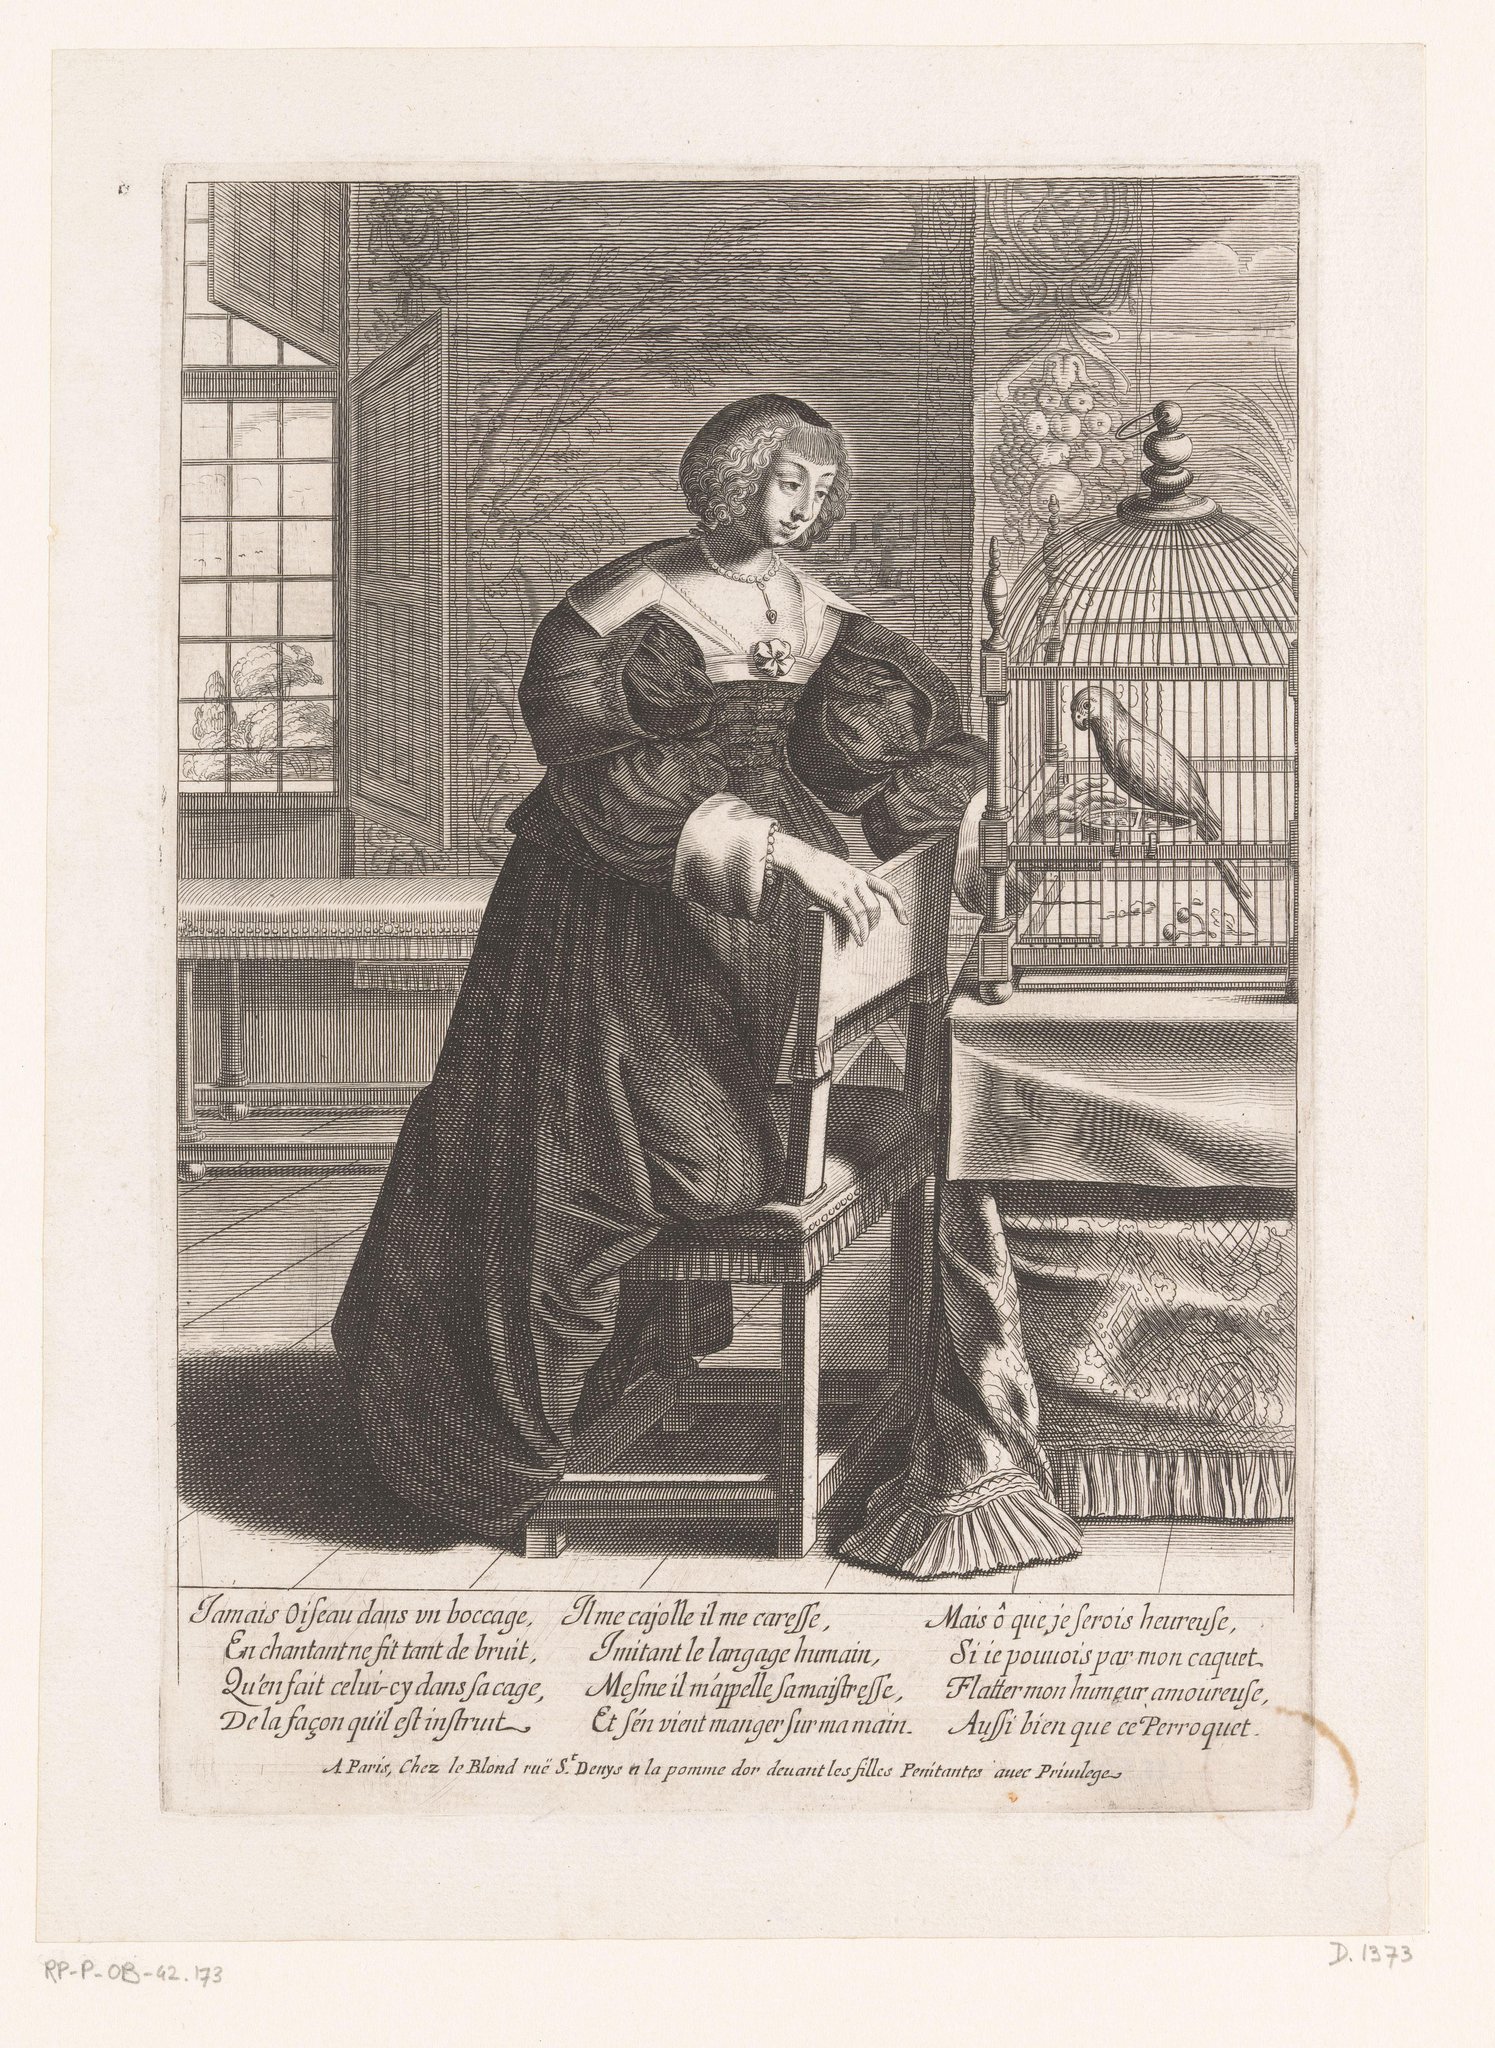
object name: print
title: Vrouw bij een papegaai in een kooi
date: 1634-1636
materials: paper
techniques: engraving, etching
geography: paris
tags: ornamental birds: parrot, interior of the house, ornamental birds: parakeet, bird in a cage, clothes, costume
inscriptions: collector's mark: Lugt 240